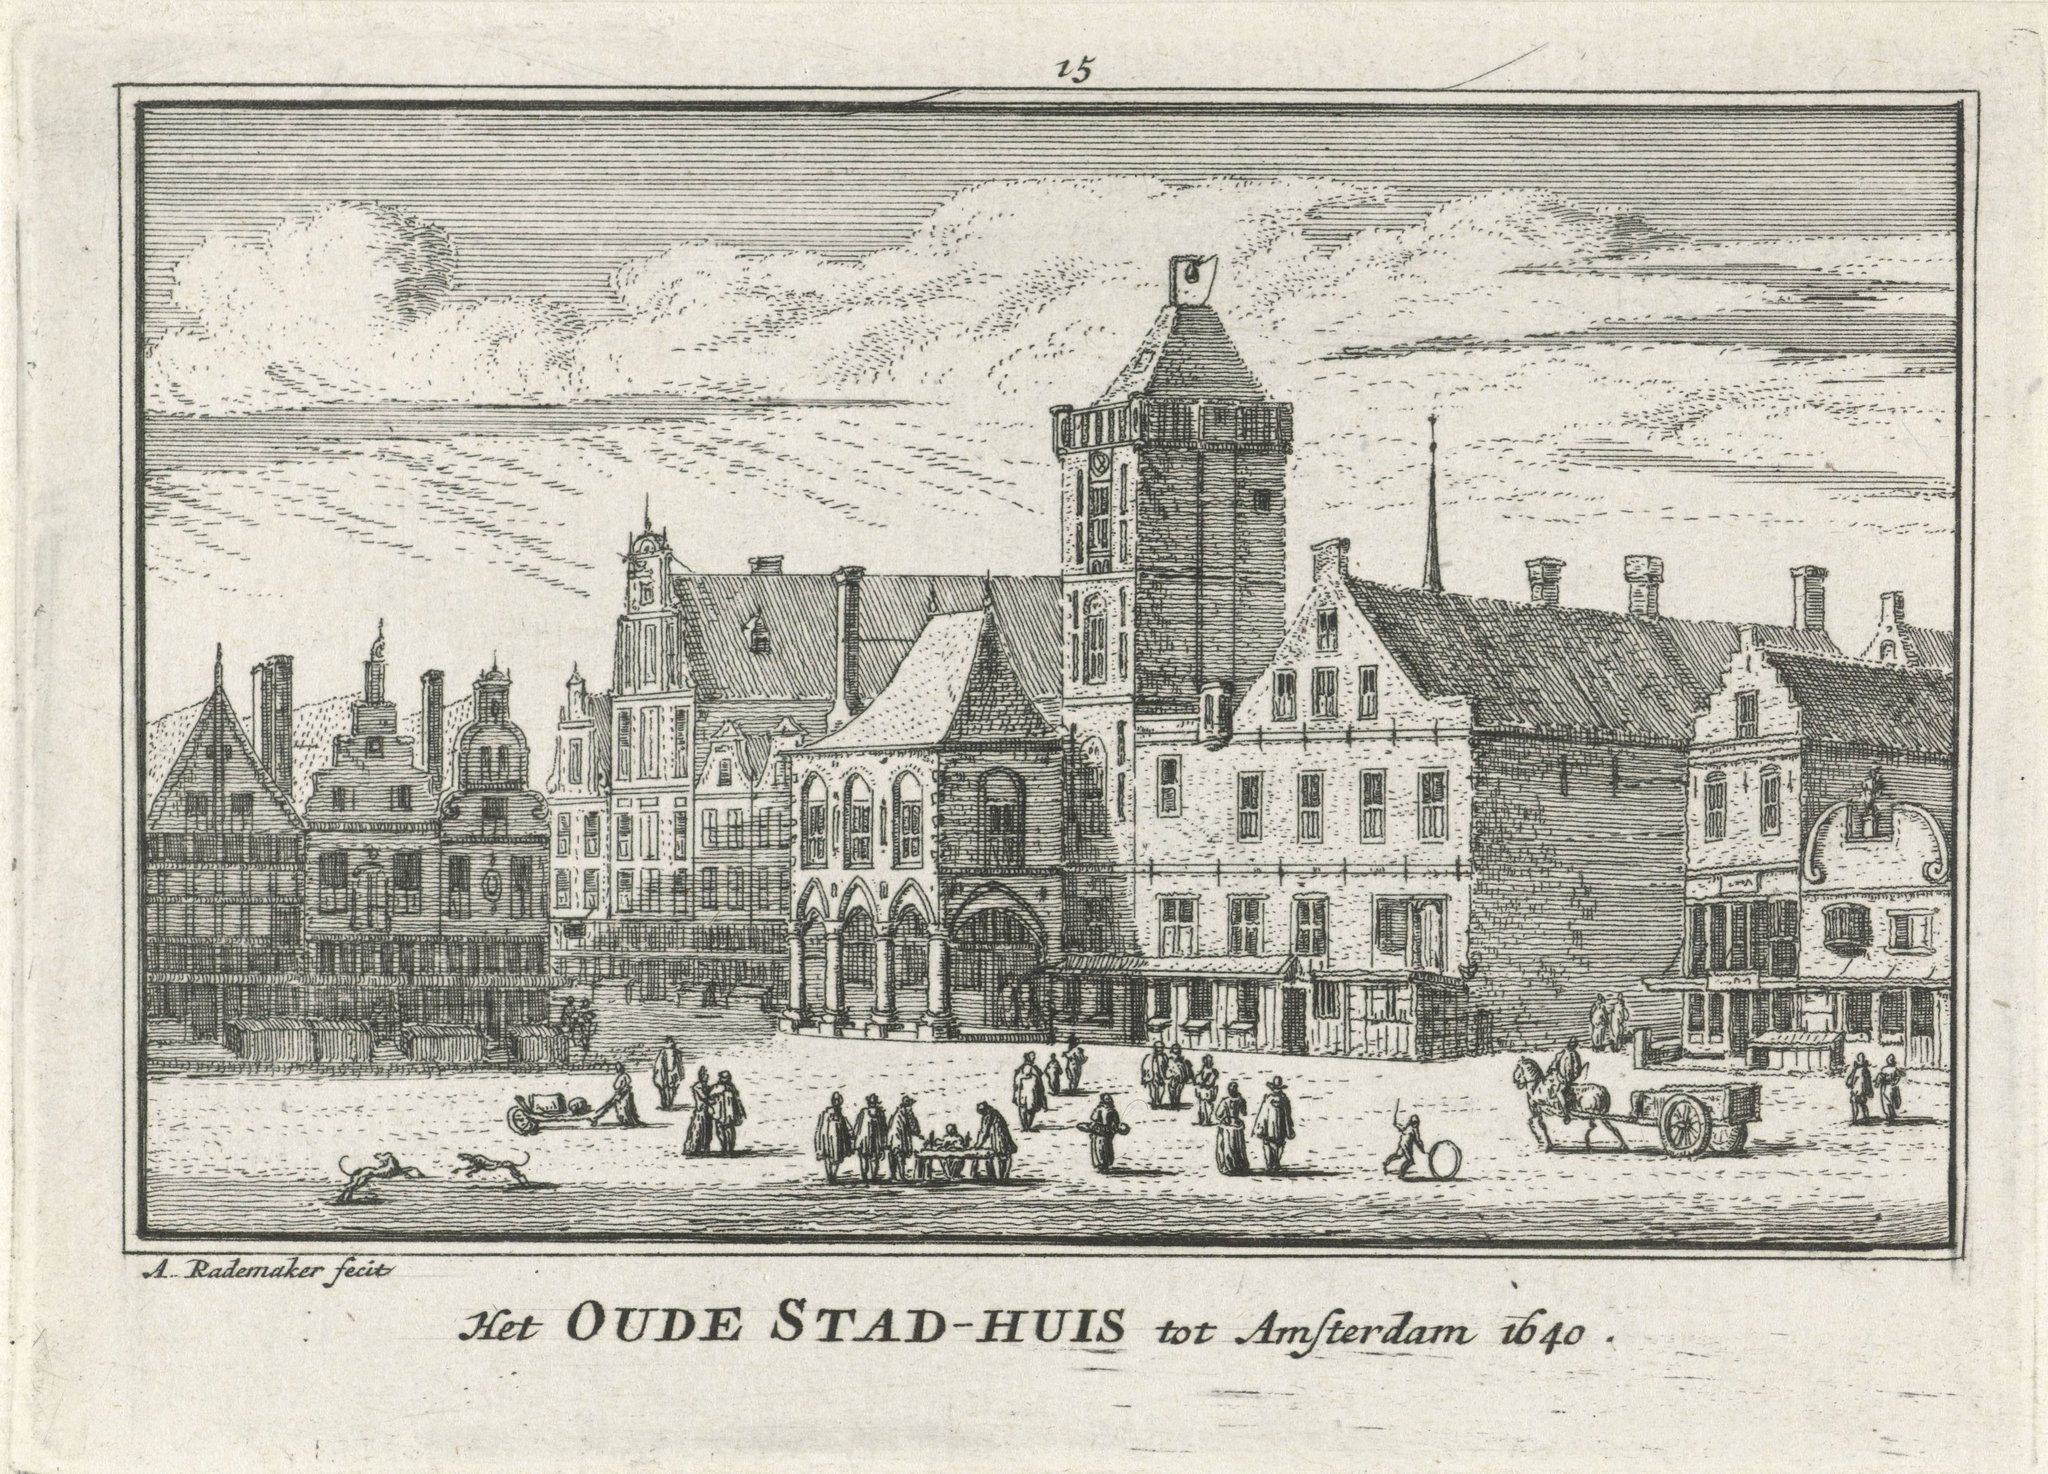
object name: print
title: Gezicht op het Oude Stadhuis van Amsterdam, 1640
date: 1727-1733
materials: paper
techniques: etching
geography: amsterdam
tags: stadhuis van amsterdam (14e eeuw-1652)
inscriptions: collector's mark: Lugt 2228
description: Illustratie uit: Abraham Rademaker, Matthaeus Brouërius van Niedek, Isaac Le Long, Kabinet van Nederlandsche en Kleefsche outheden en (...) voorname stads- en landgebouwen, Willem Barents en Antoni Schoonenburg: Amsterdam, 1727-1733, ill. nr. 15